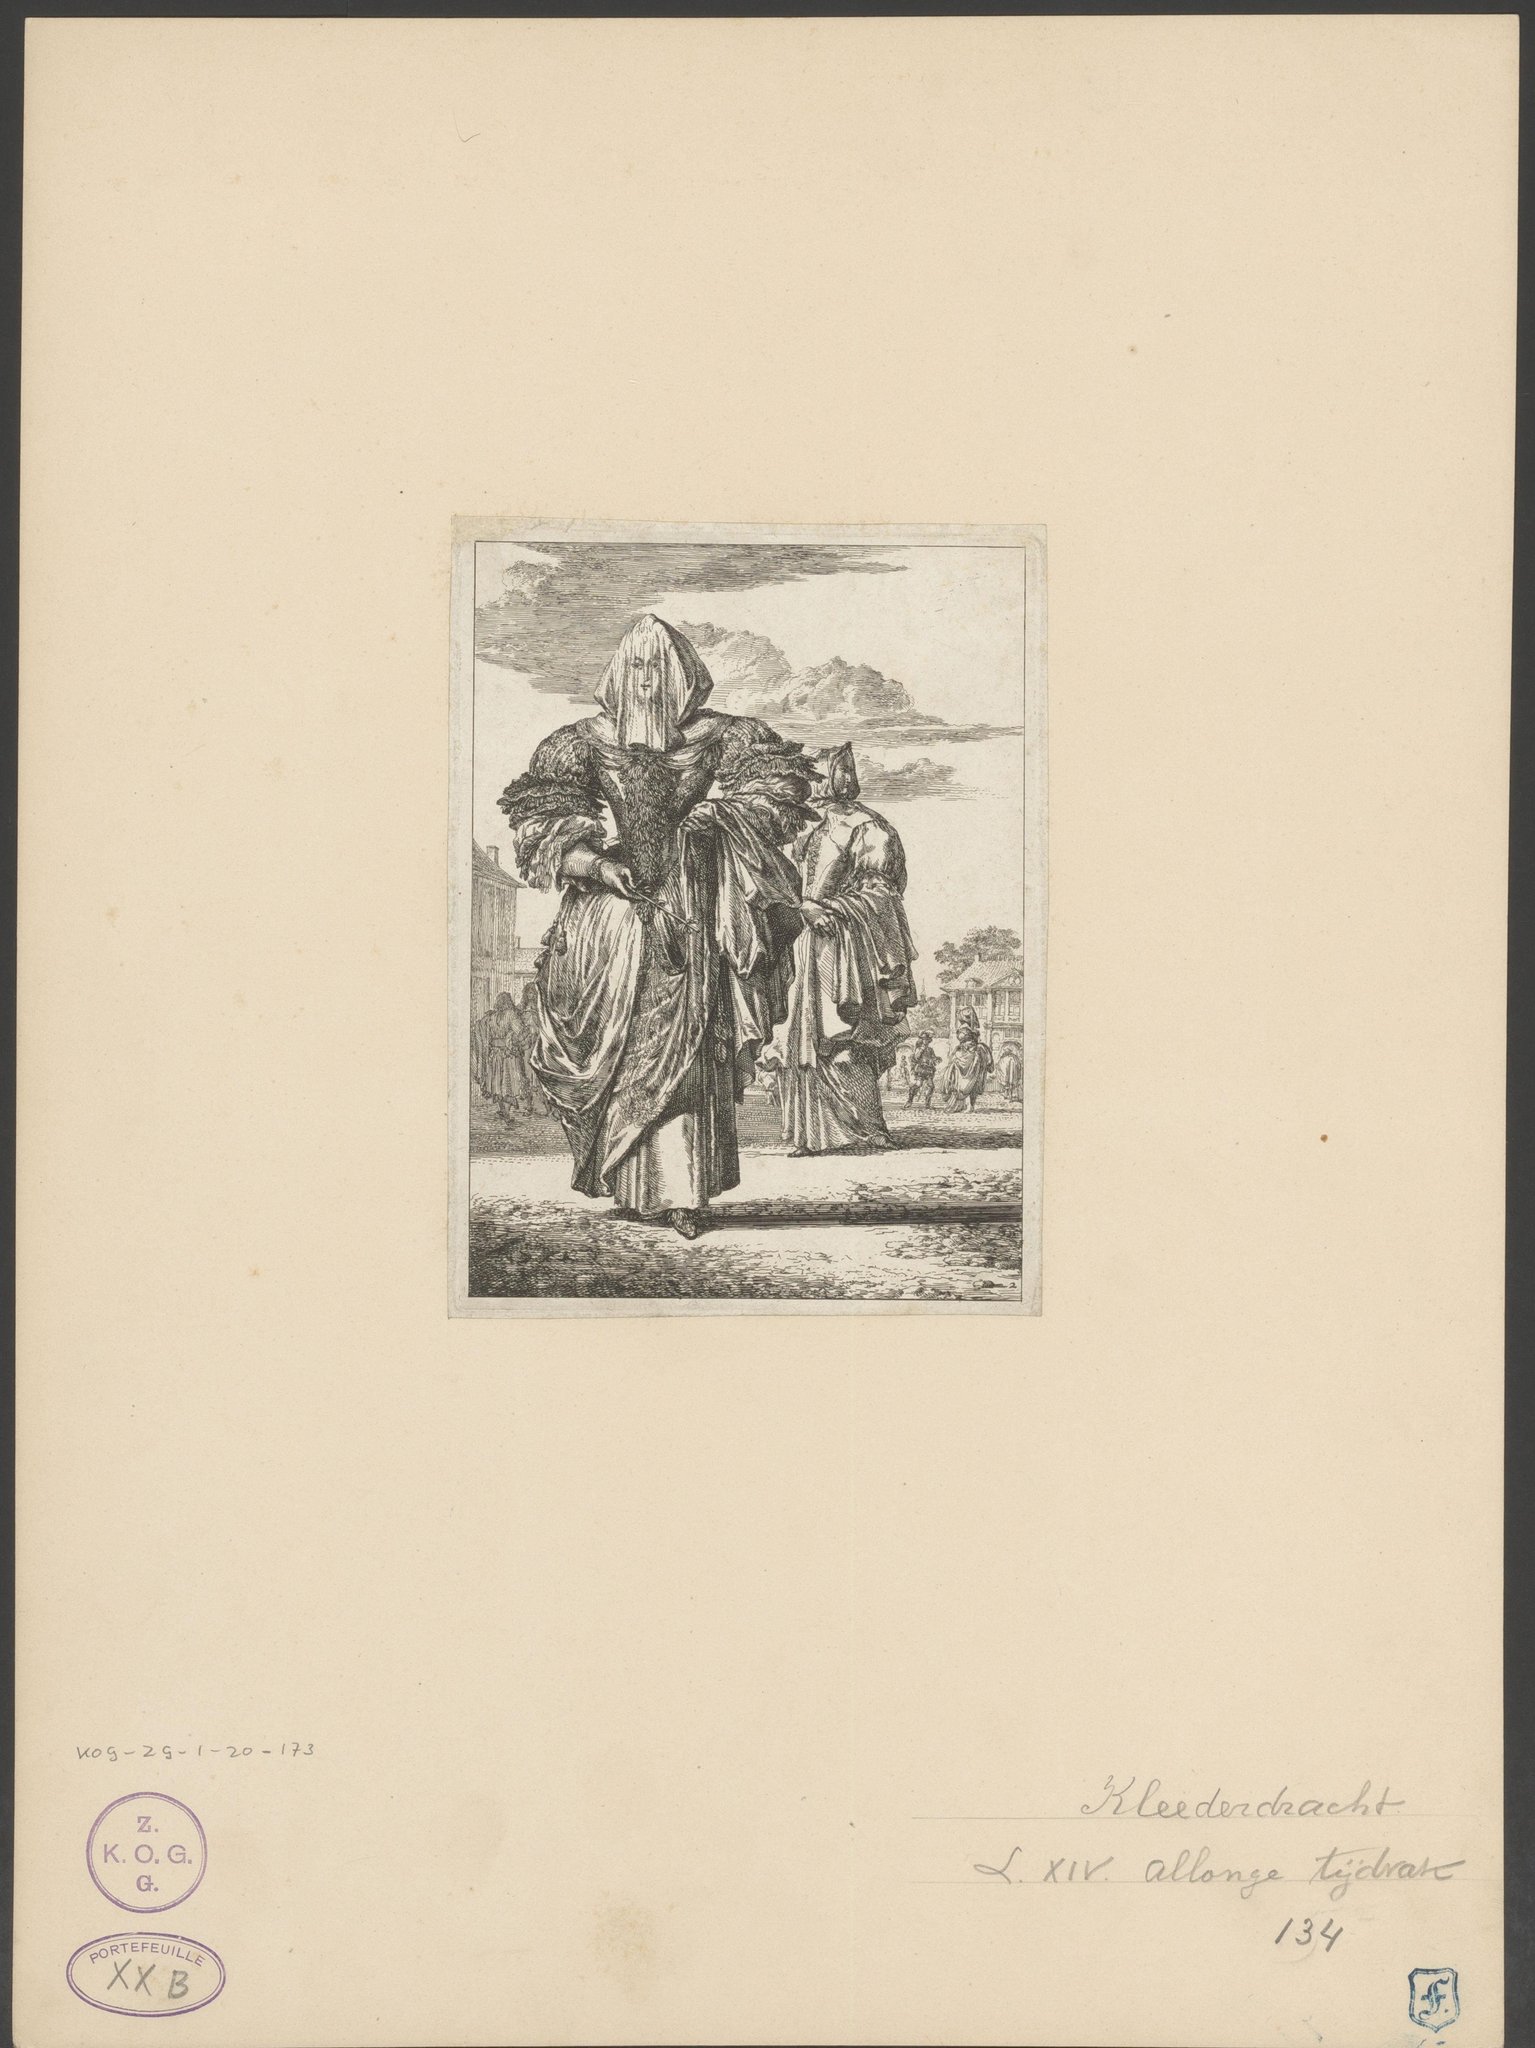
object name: print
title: Figures à la mode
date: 1662-1702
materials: paper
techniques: etching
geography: amsterdam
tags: veil (+ women's clothes), fashion plates, dress, gown (+ women's clothes)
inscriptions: collector's mark: Lugt 1641, collector's mark: Lugt 1641, stamp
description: Gesluierde vrouw staat op het stadsplein. Zij is gekleed in lange japon met brede pofmouwen, versierd met linten. Rechtsonder genummerd: 2. Onderwerpsrubrieken binnen de Atlas Zeden en Gewoonten: Zeden en Gewoonten in Engeren Zin, De Kleeding, Kleederdrachten (tijdvakken), Lodewijk XIV (1650 – 1720). Het allonge tijdvak).